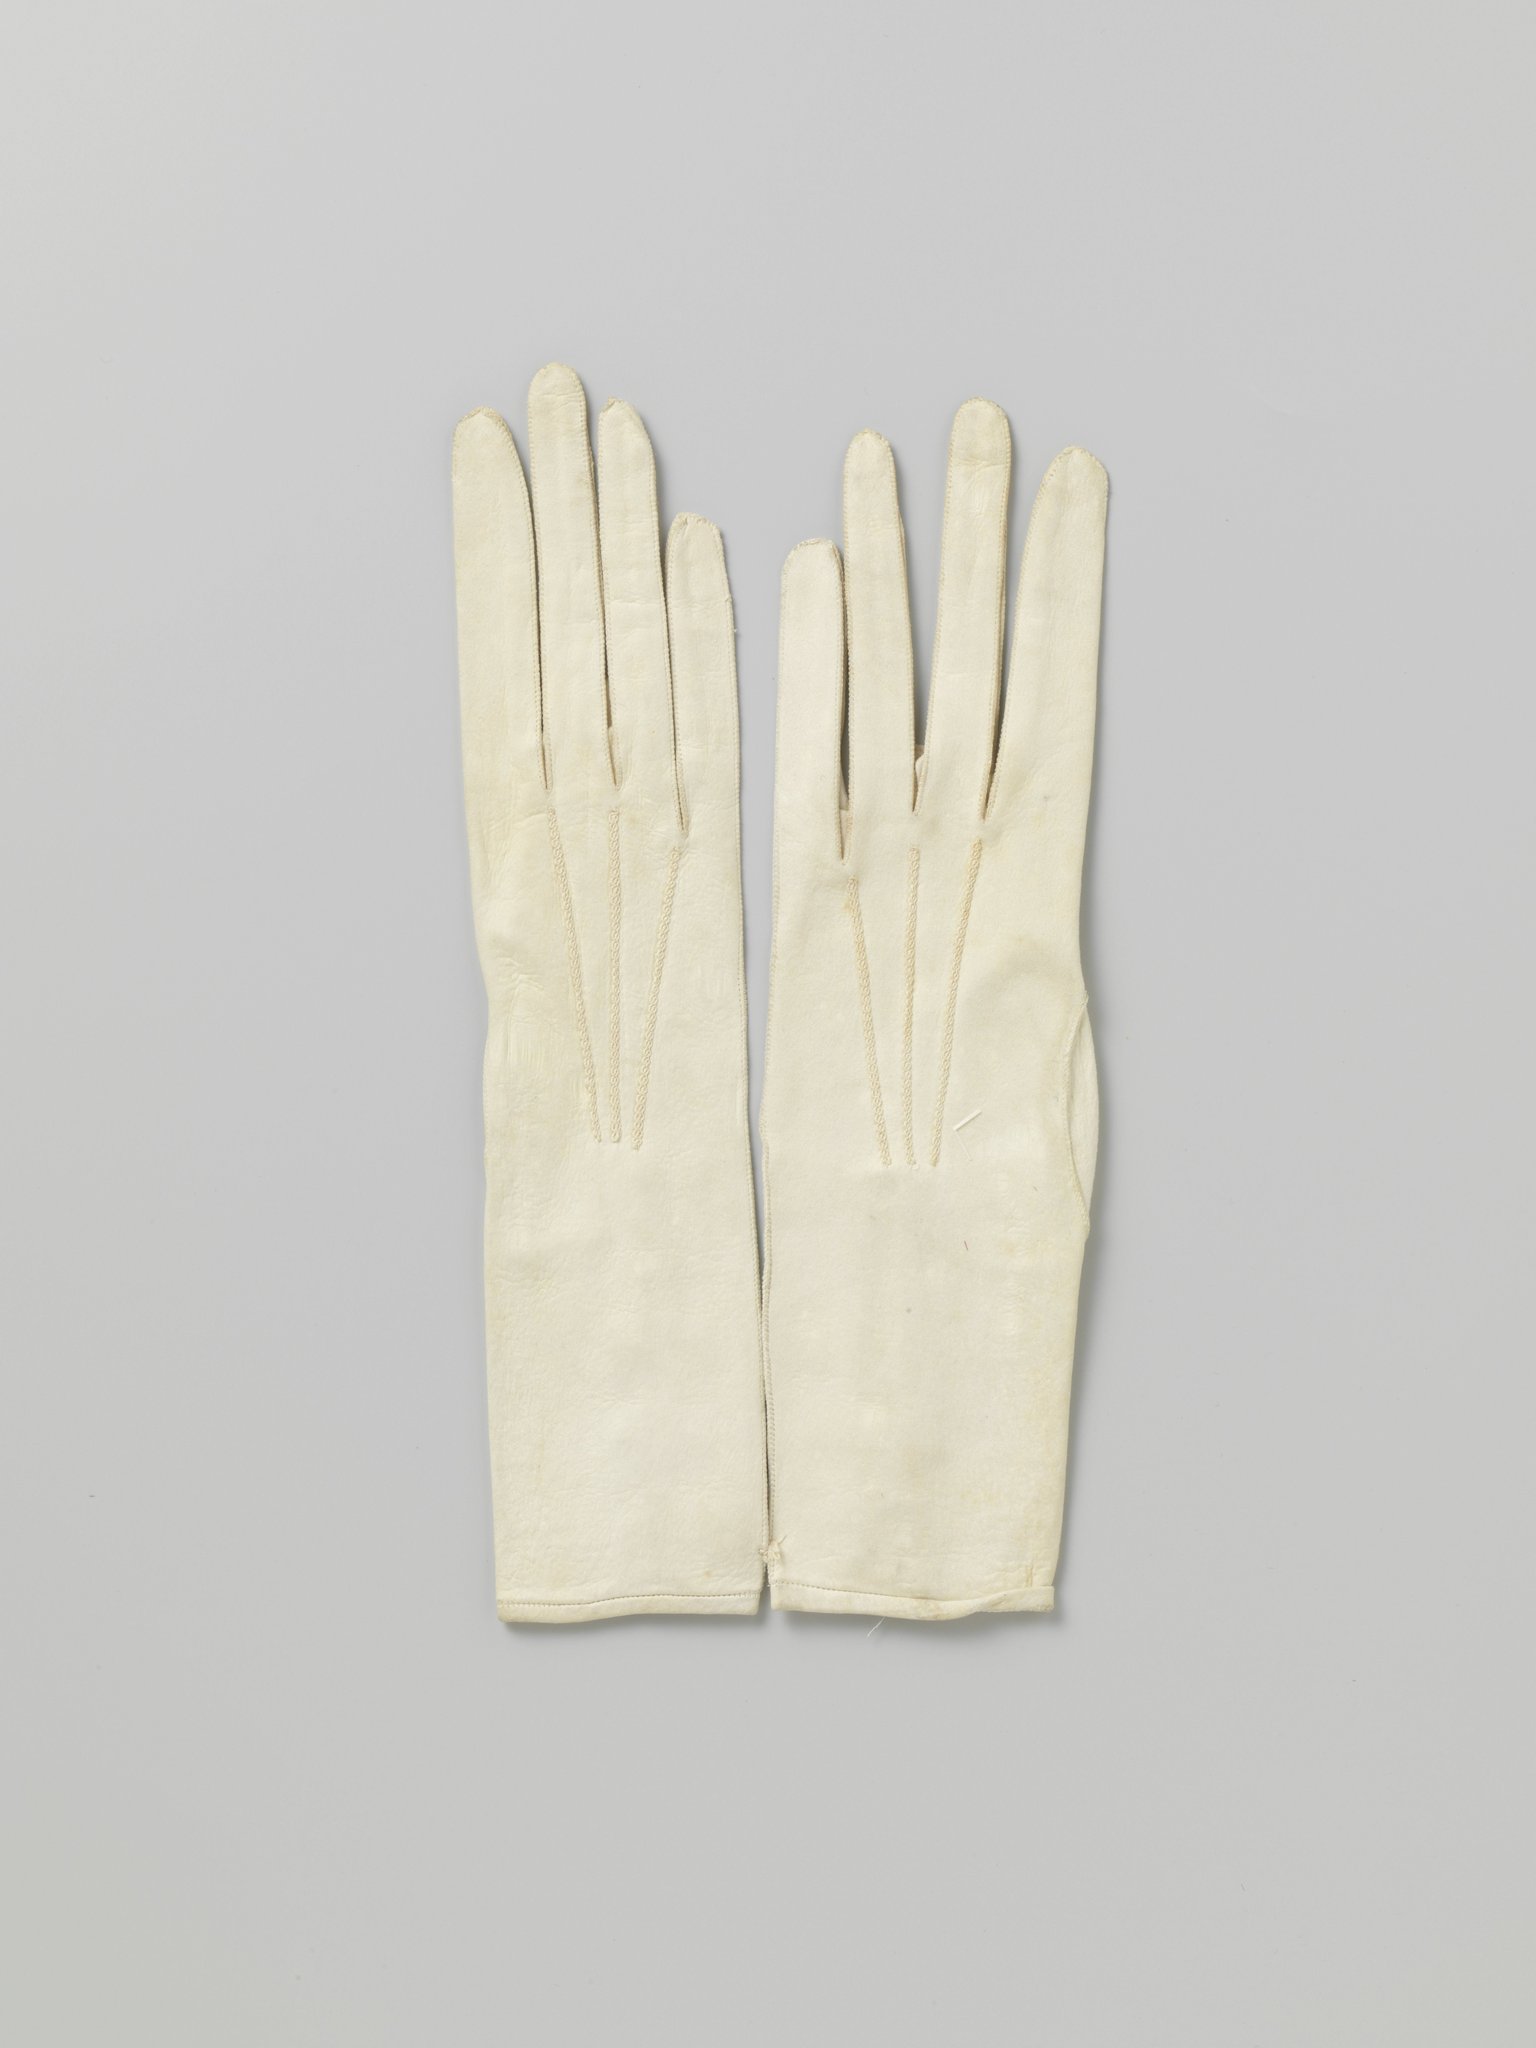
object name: glove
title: Two pairs of gloves with buttons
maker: Anonymous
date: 1900-1925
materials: leather, mother of pearl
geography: genoa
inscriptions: stamp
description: Dameshandschoen, één van wit zeemleer. Belle-epoque-art déco: Model: kort en respectievelijk met drie parelmoeren knoopjes. Versiering: Op de plaats van de pezen zijn op de handruggen drie uitstralende koordjes genaaid, ter verslanking. Toestand: No. a. winkelnieuw; de twee zijn nog met een draadje als paar bijeengehouden.